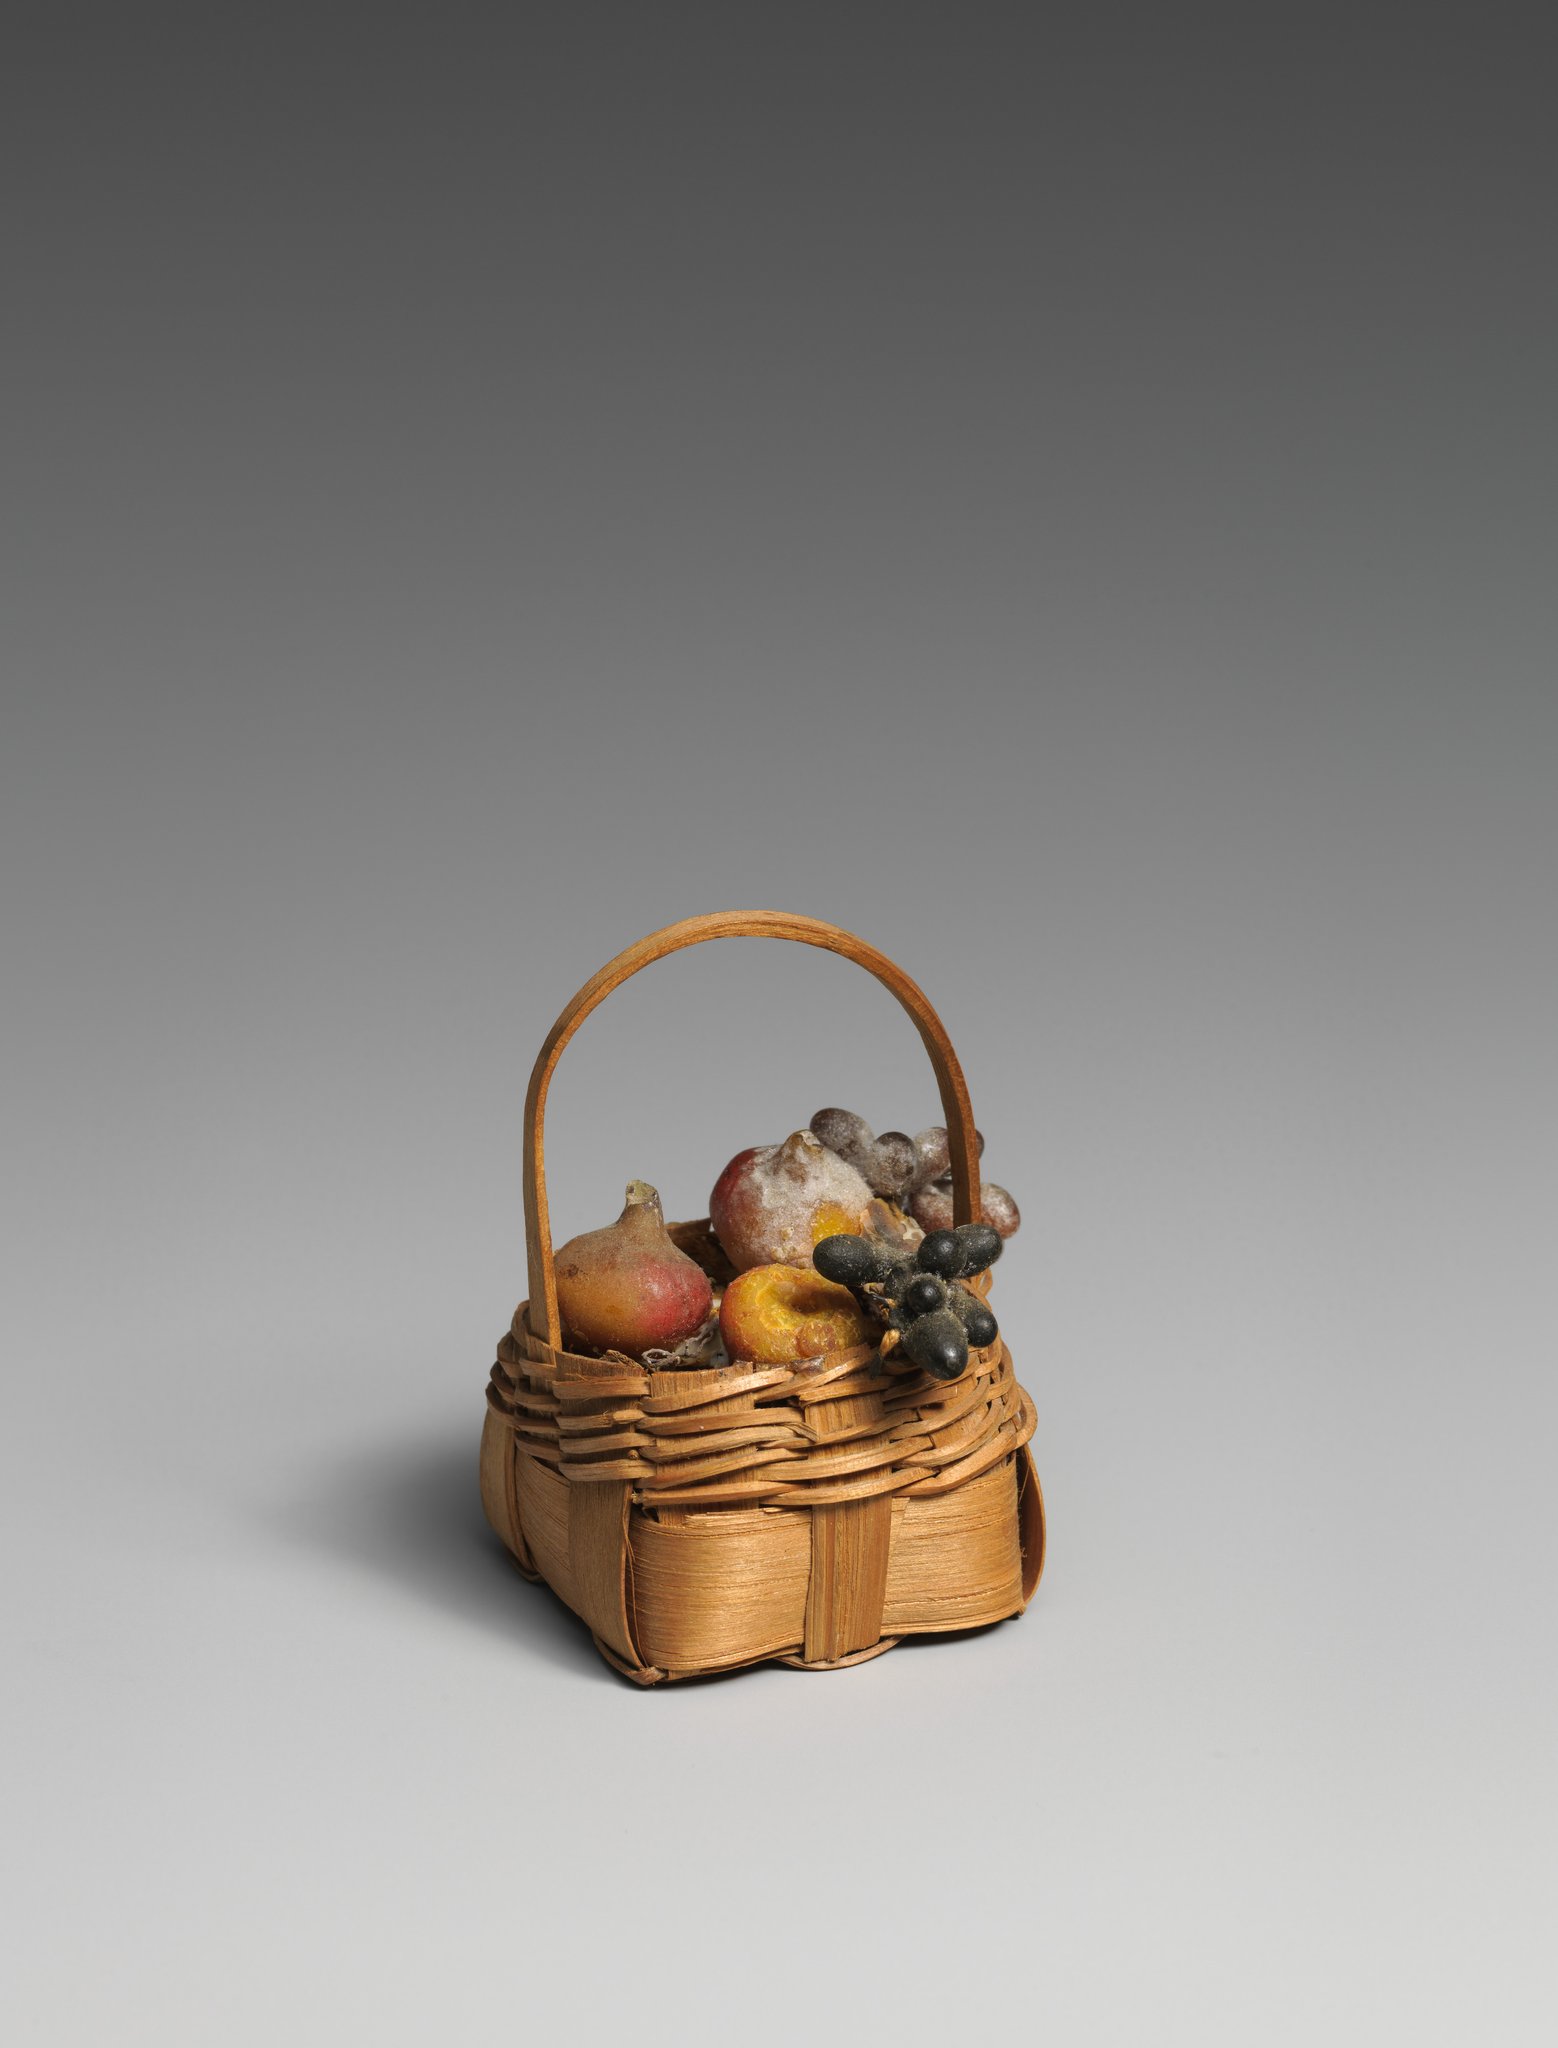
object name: crèche accessory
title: Handled basket with fruit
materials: wax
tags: fruit